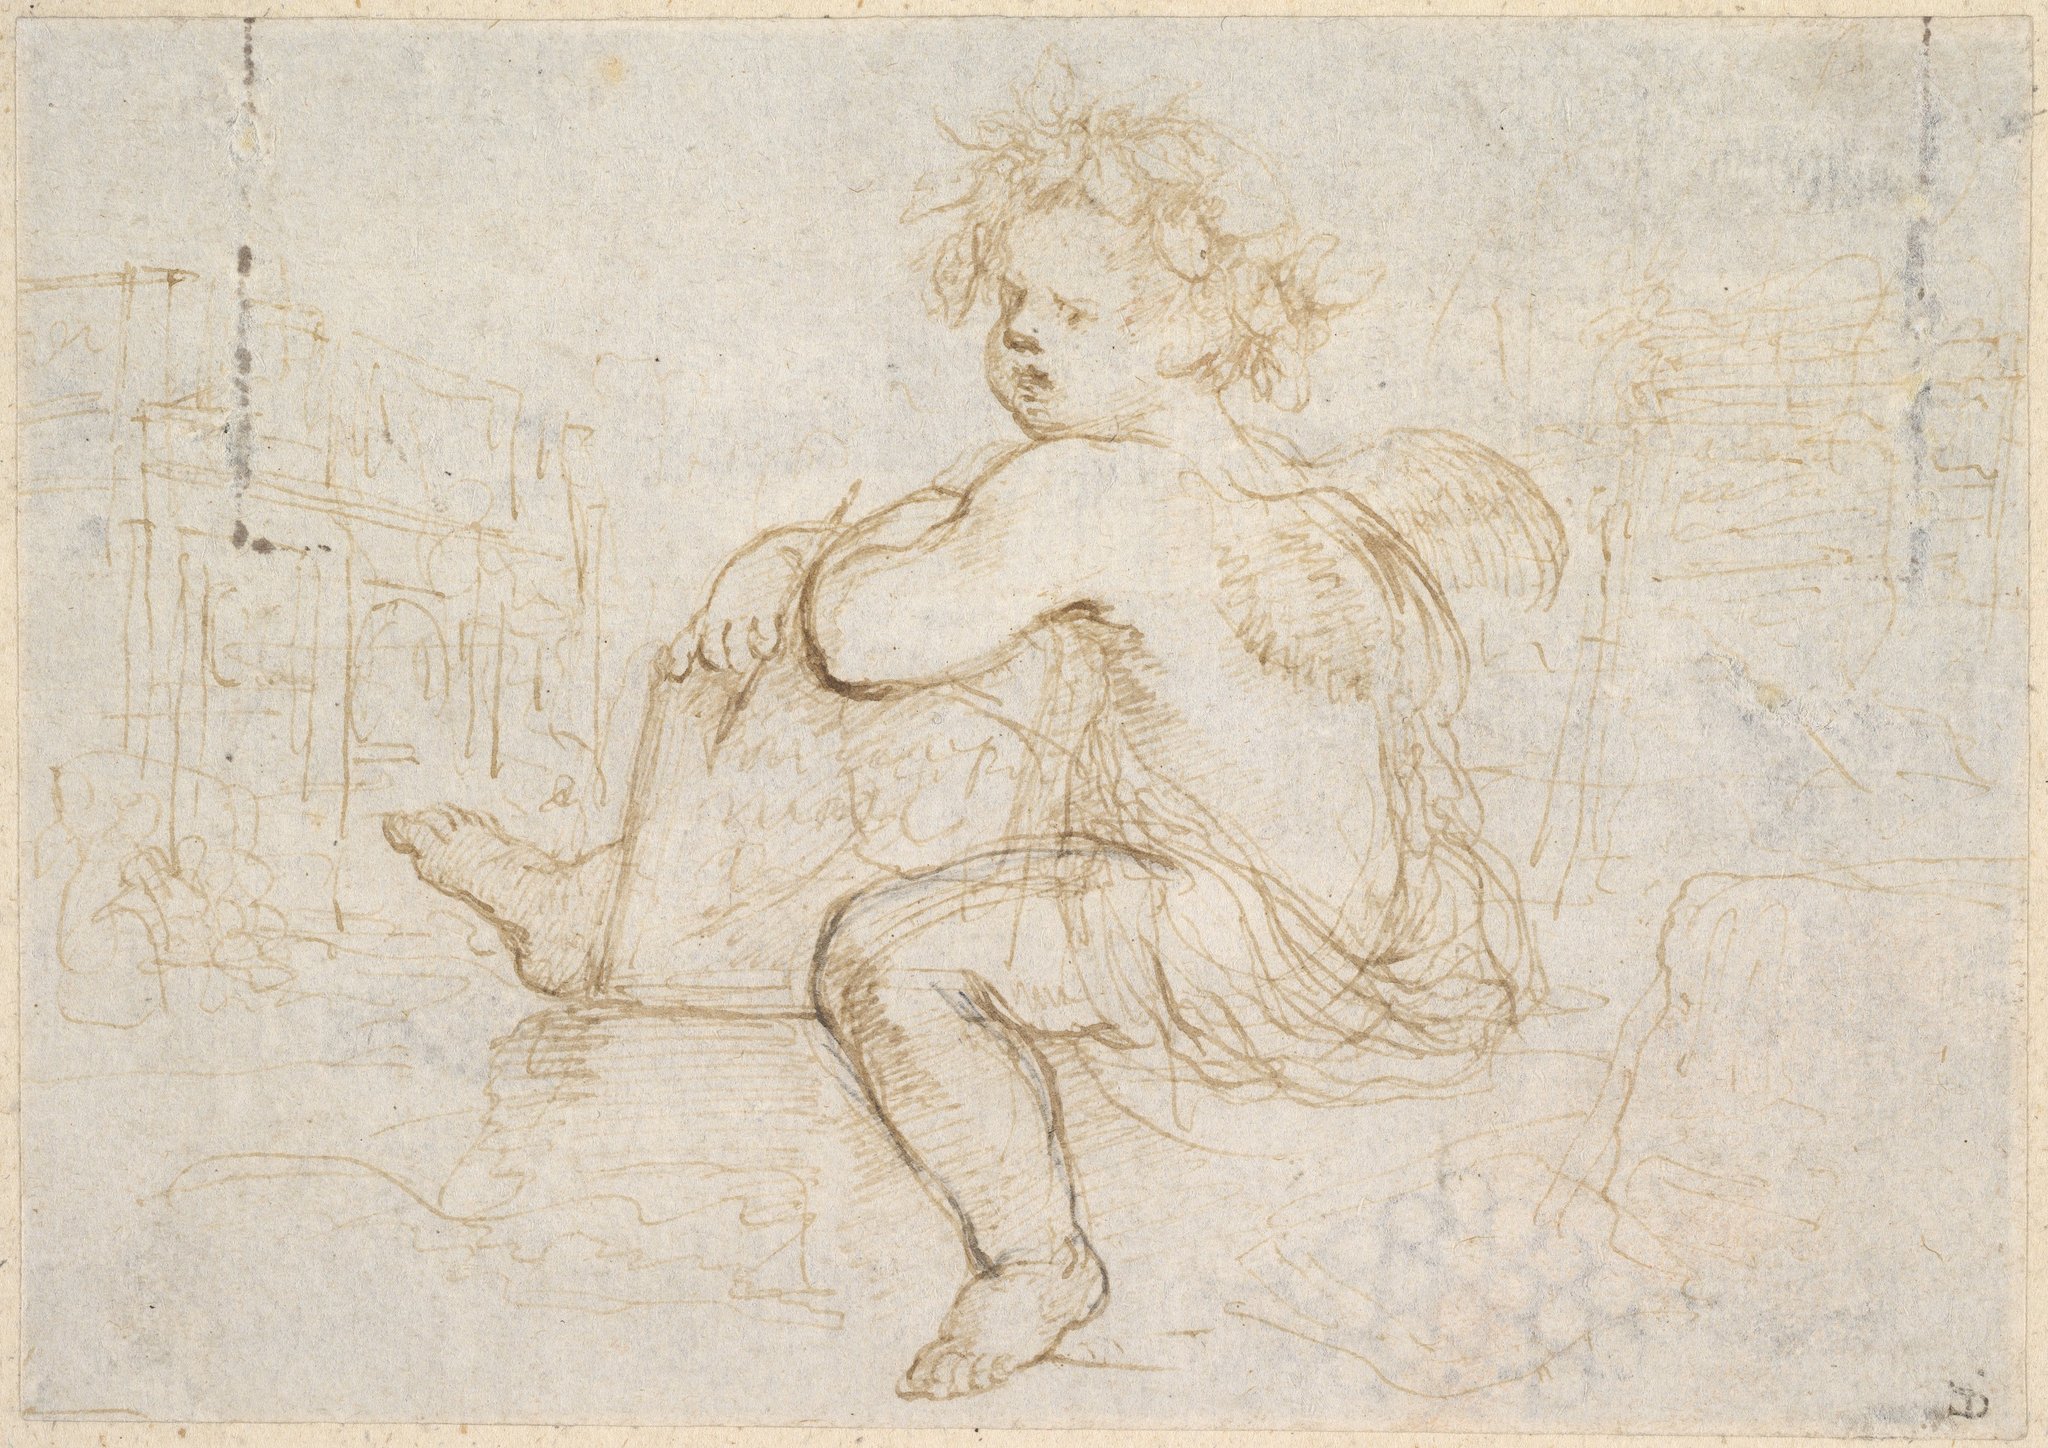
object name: drawing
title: Genie of Drawing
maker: stefano della bella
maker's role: artist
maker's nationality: italian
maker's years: 1610-1664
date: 1610-1664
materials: ink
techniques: pen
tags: drawing